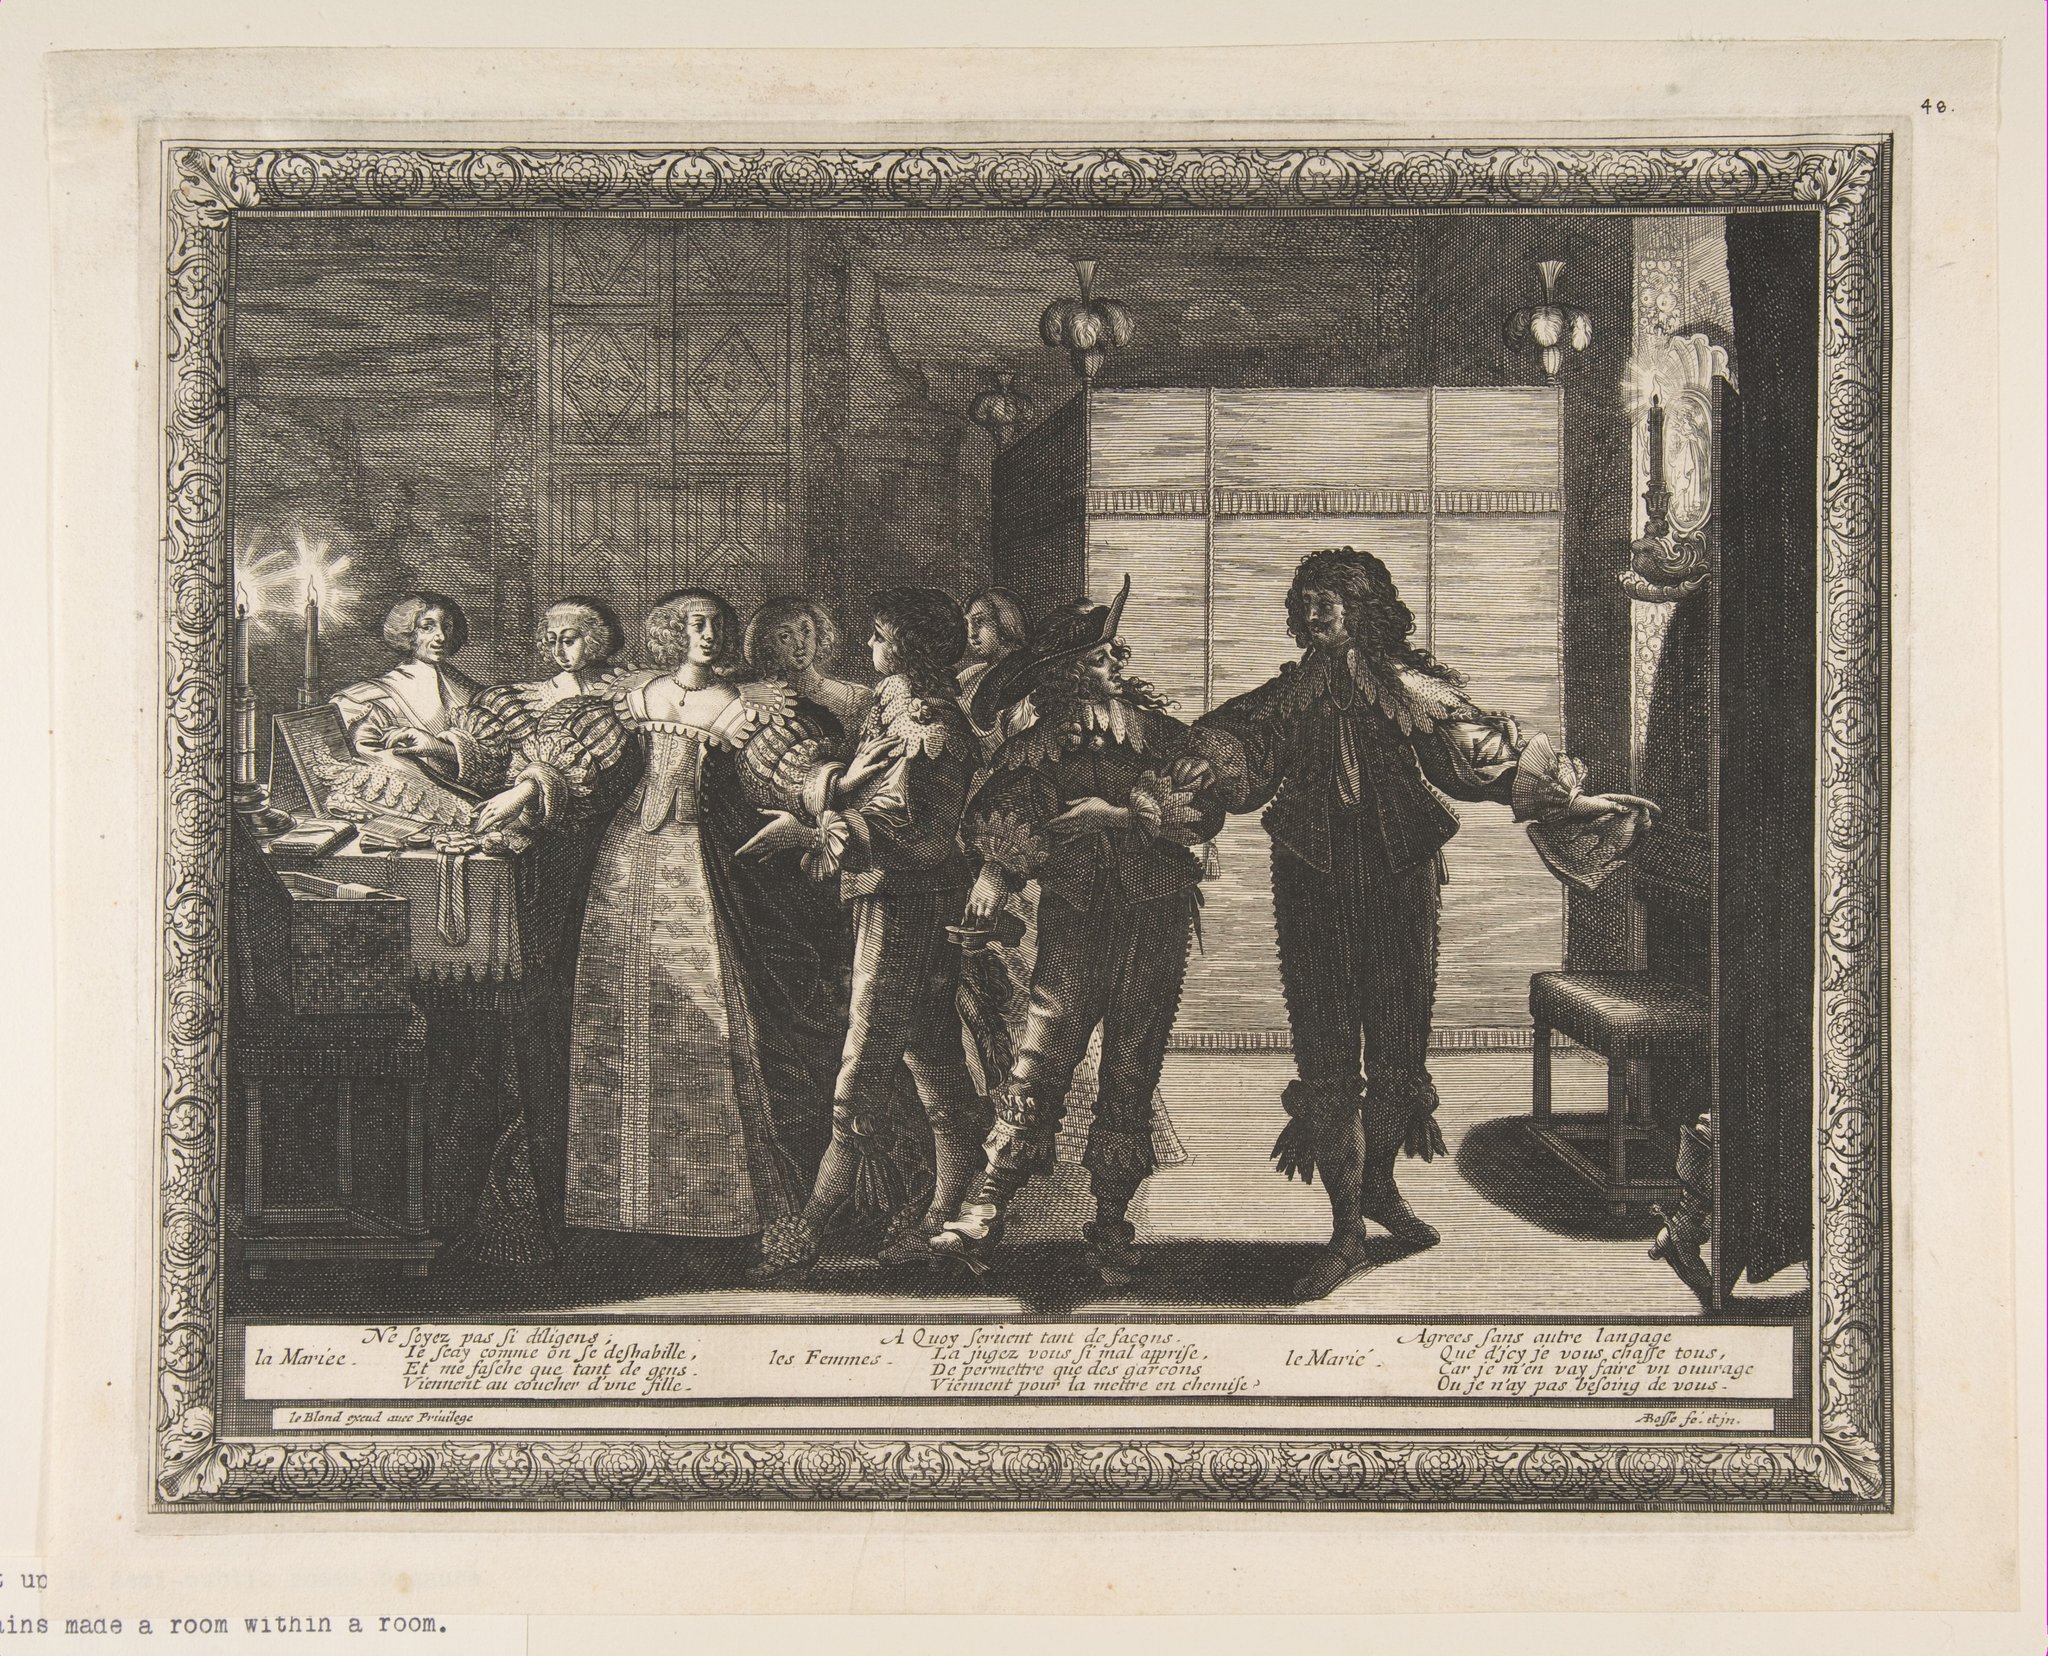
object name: print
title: The Bride Taken Home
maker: abraham bosse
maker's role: artist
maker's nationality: french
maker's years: 1602-1676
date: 1633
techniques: etching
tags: men,women